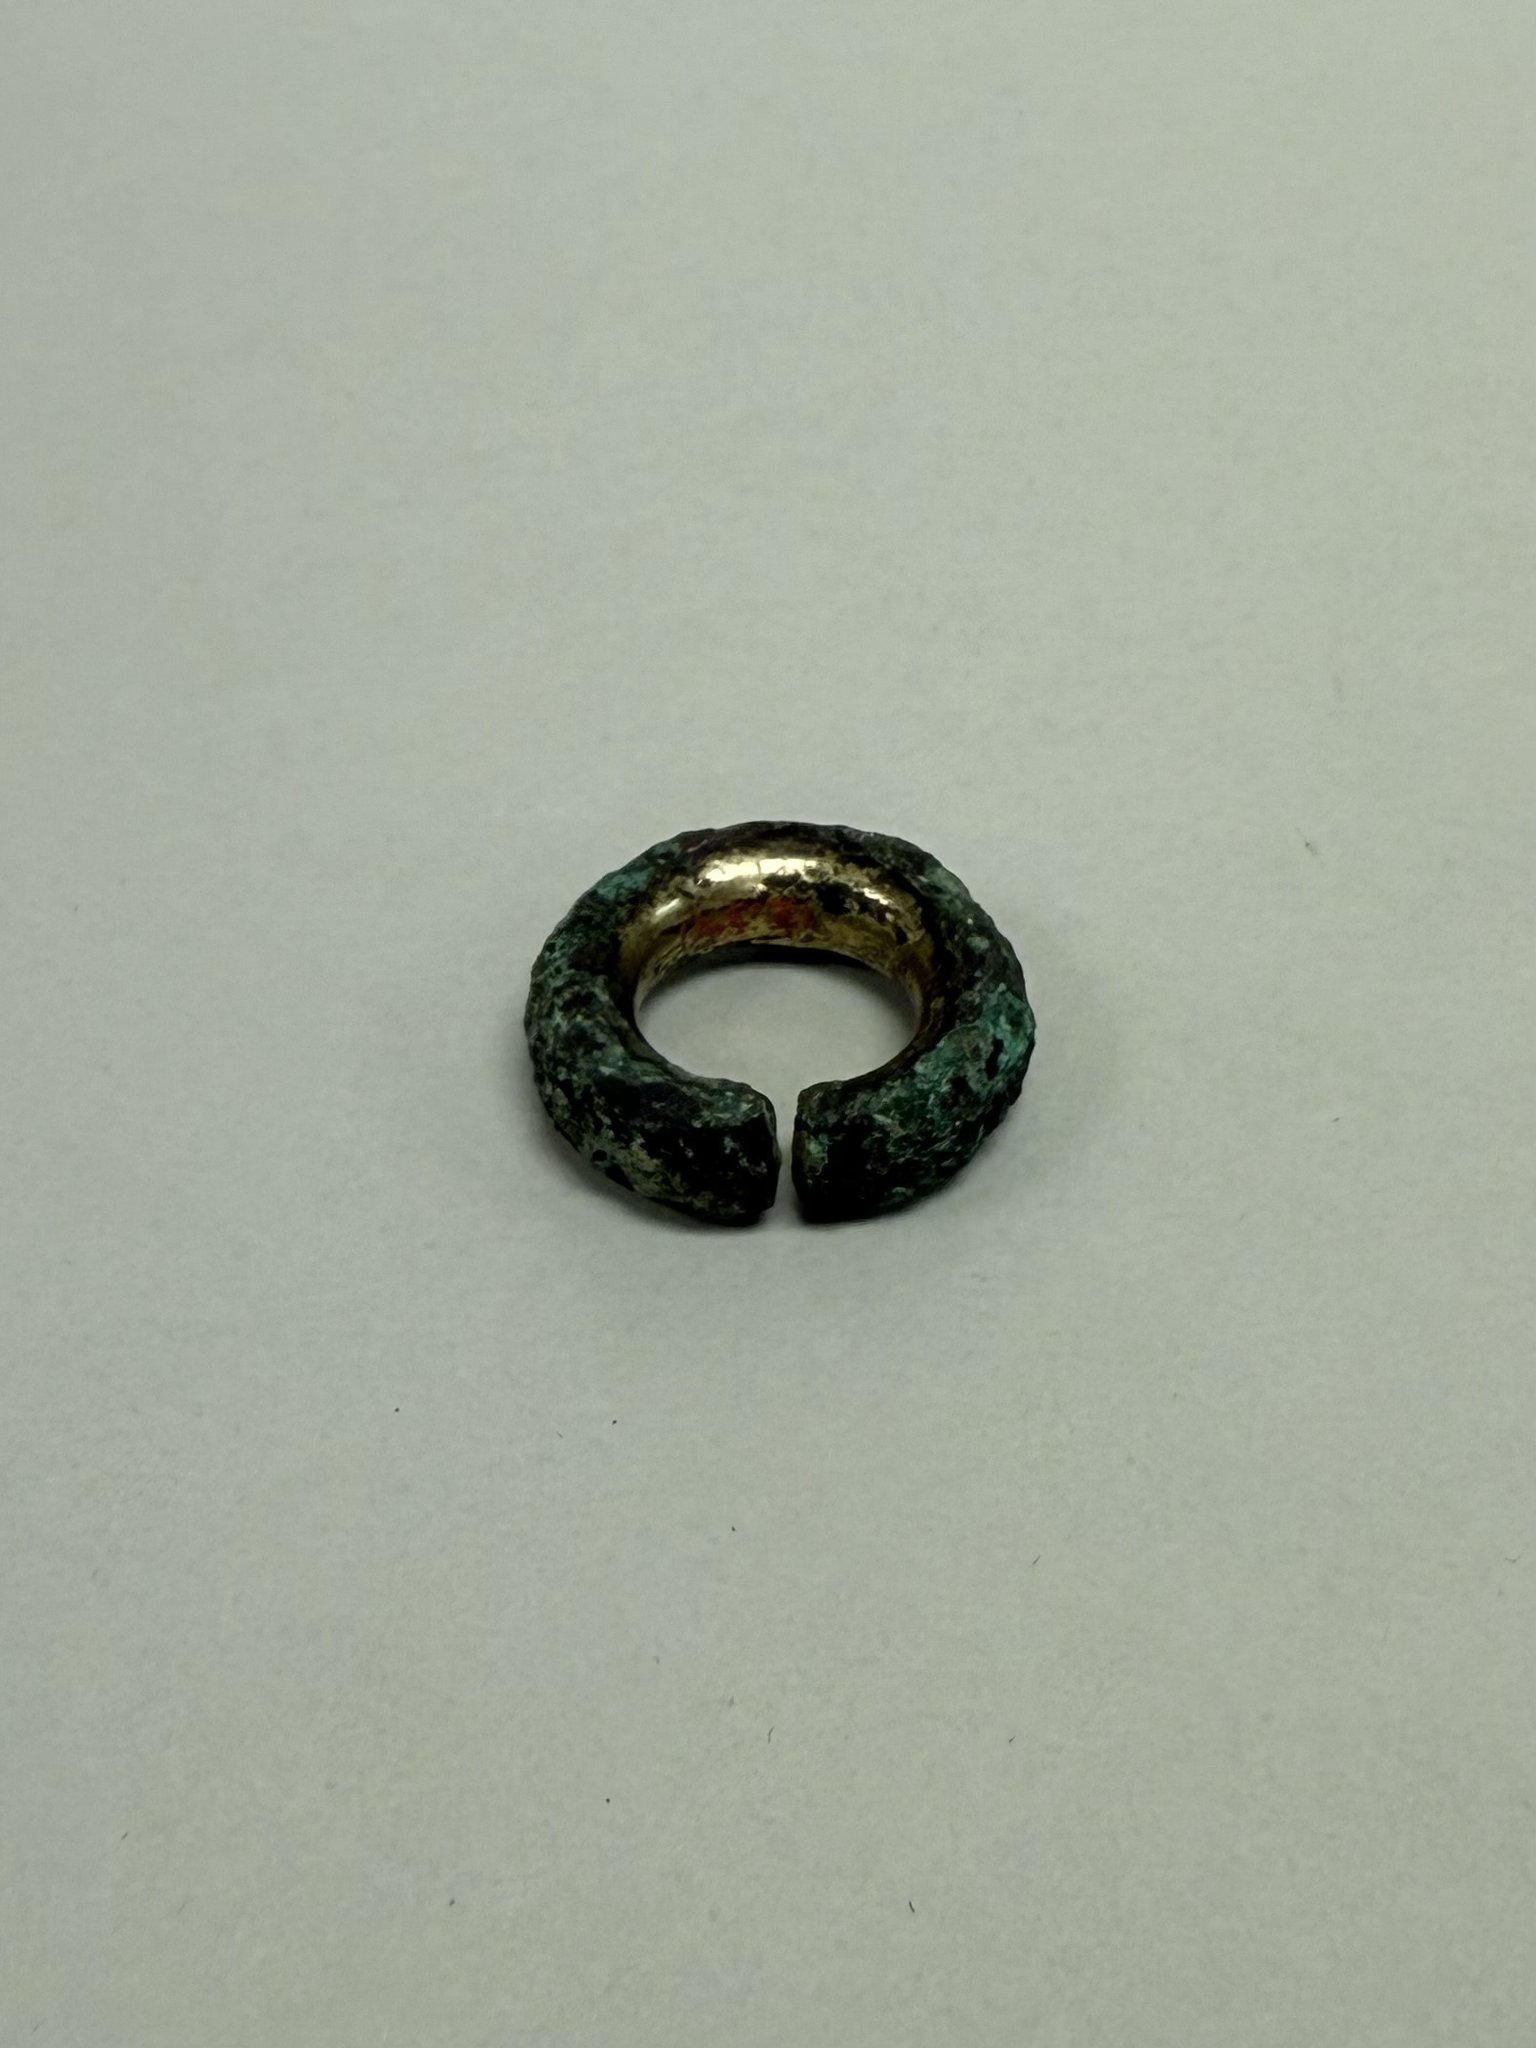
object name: earring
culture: japanese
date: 601-700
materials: copper gilt